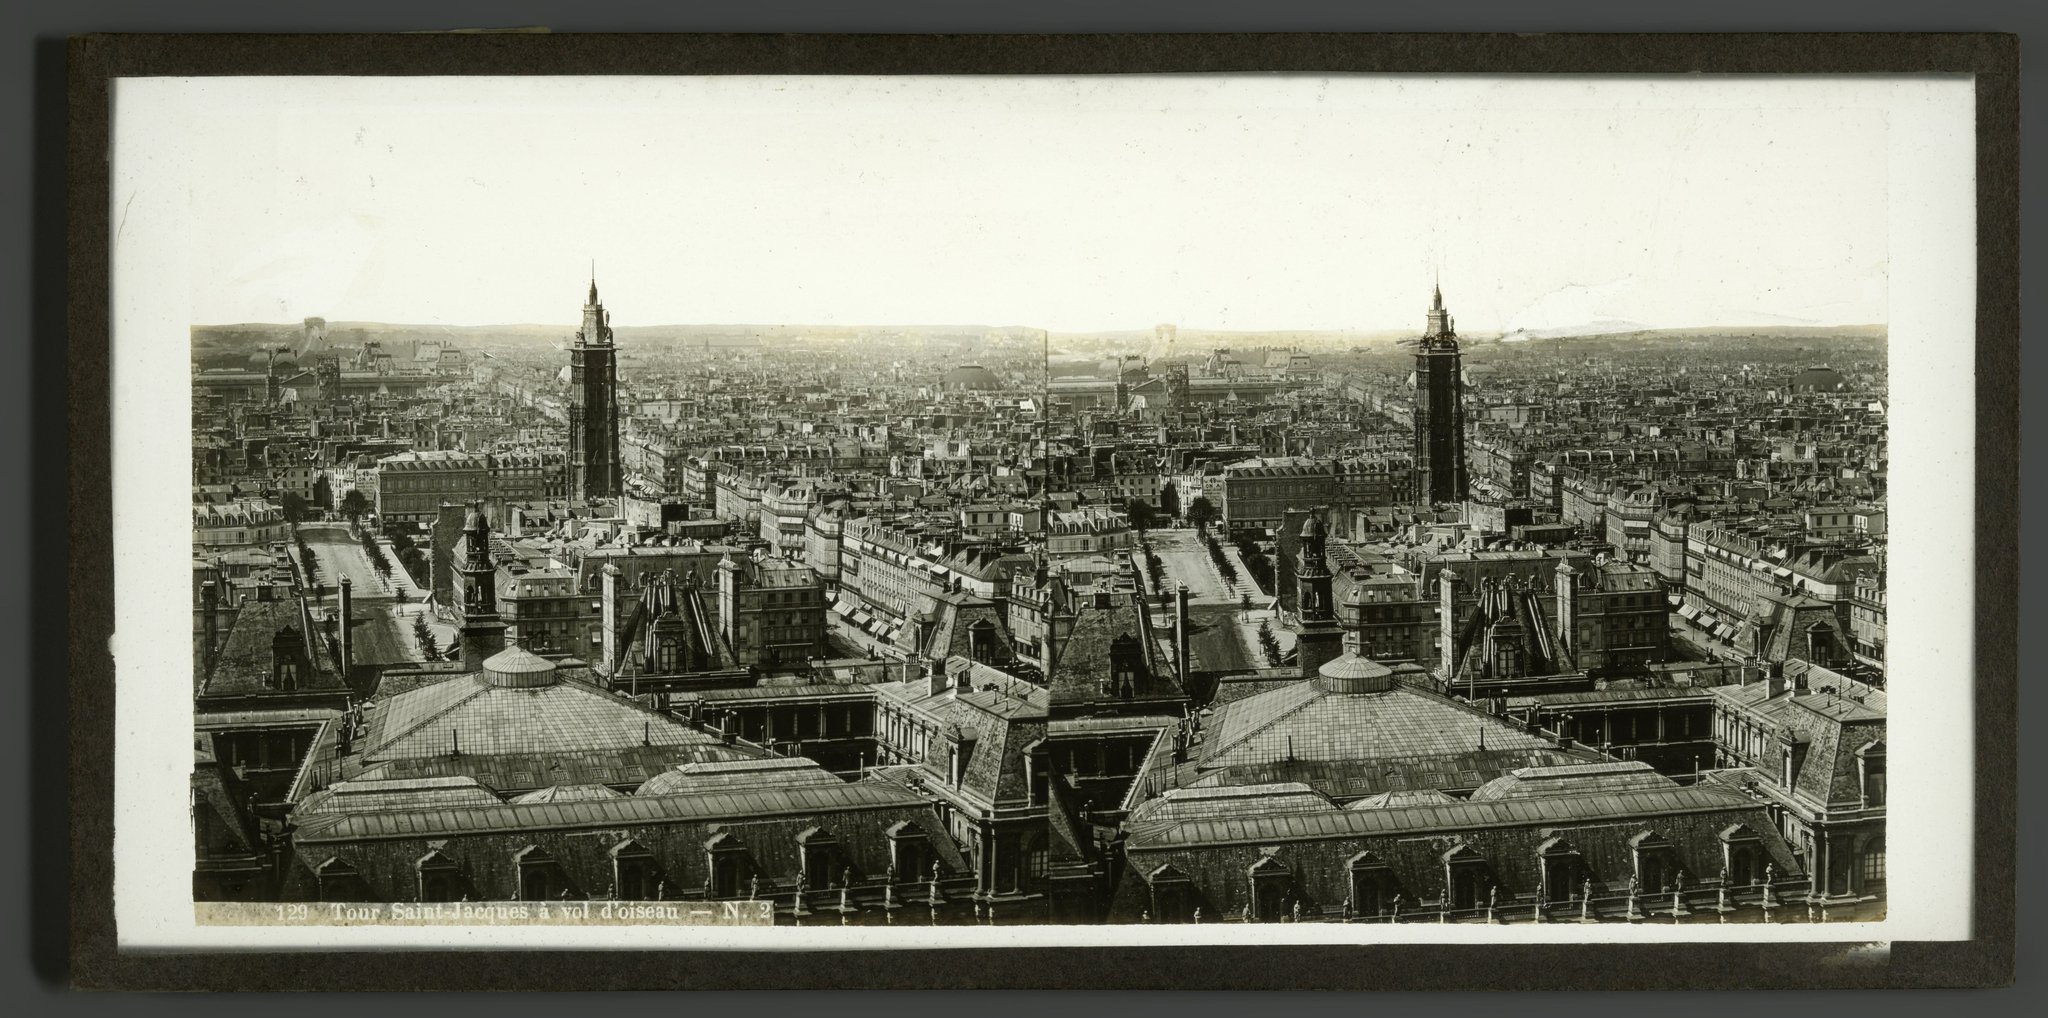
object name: stereoscopic photograph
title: Gezicht op Parijs met de Tour Saint-Jacques, Frankrijk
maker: Anonymous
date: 1856-1890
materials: glass, paper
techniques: slide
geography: paris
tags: prospect of city, town panorama, silhouette of city, parts of church exterior and annexes: tower, paris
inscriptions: number: ‘129’